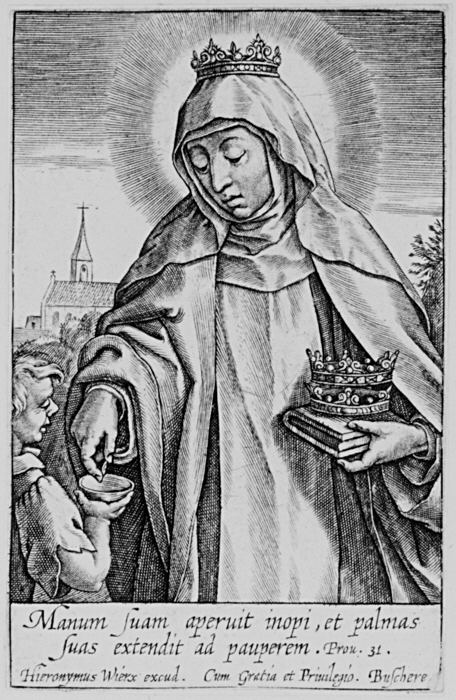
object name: print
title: St. Elizabeth of Hungary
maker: hieronymus wierix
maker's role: artist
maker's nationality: netherlandish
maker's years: 1553-1619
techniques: engraving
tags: books,churches,saints